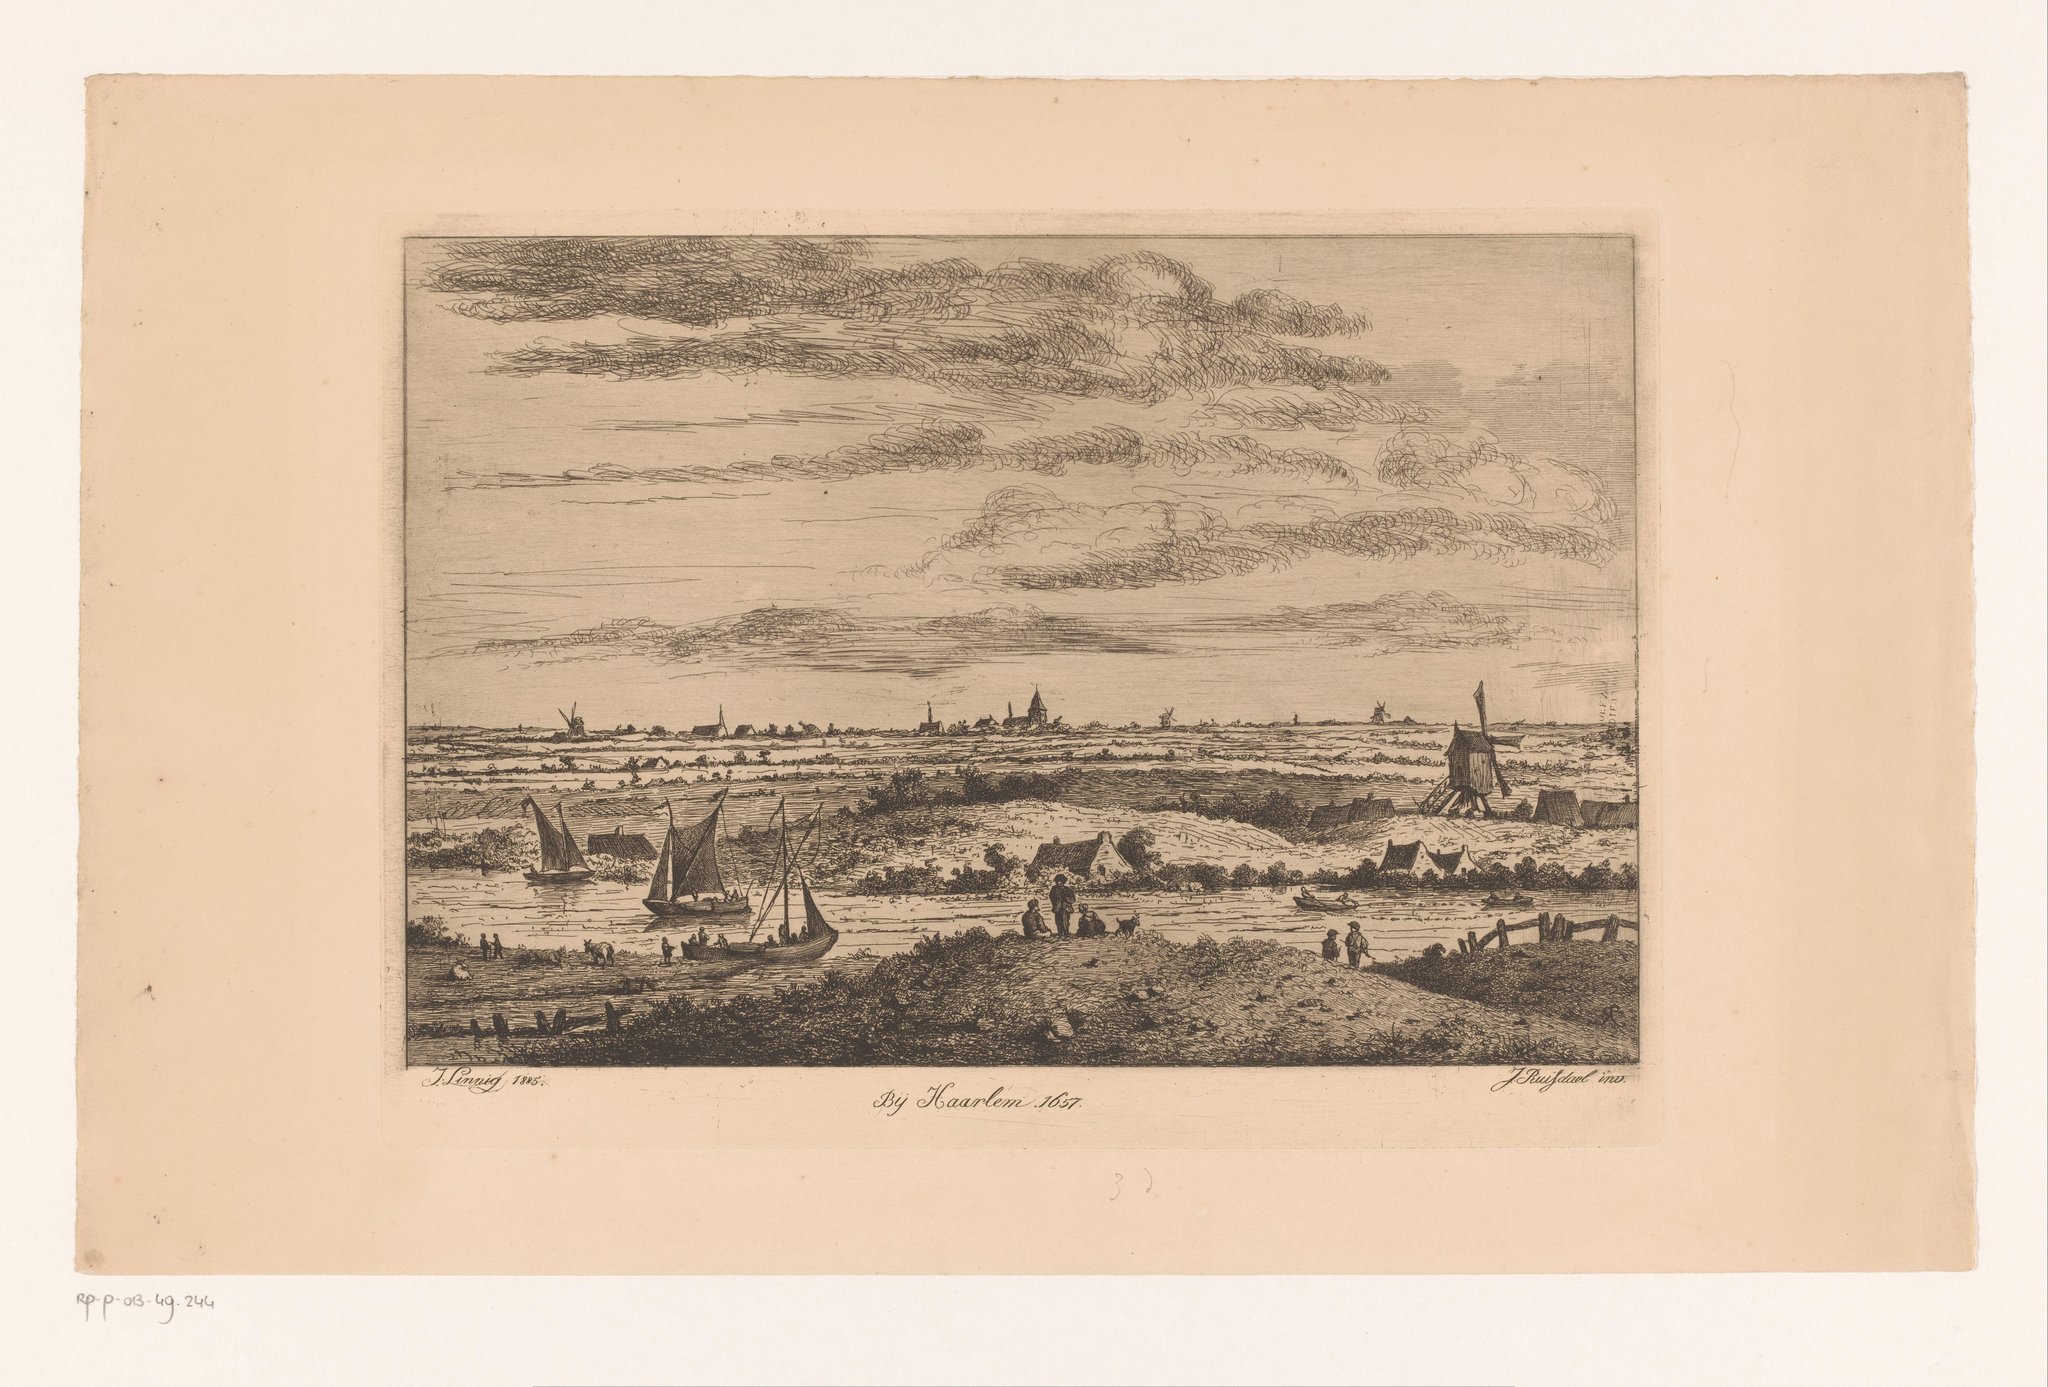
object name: print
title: Landschap in de buurt van Haarlem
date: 1885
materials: paper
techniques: etching, intaglio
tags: sailing-ship, sailing-boat, landscapes in the temperate zone, windmill in landscape, haarlem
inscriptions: date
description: In de rechterzijde van de prent een moeilijk leesbaar stempel met een adres. Dit komt voor op alle staten van deze prent in de collectie van het Rijksmuseum Amsterdam.